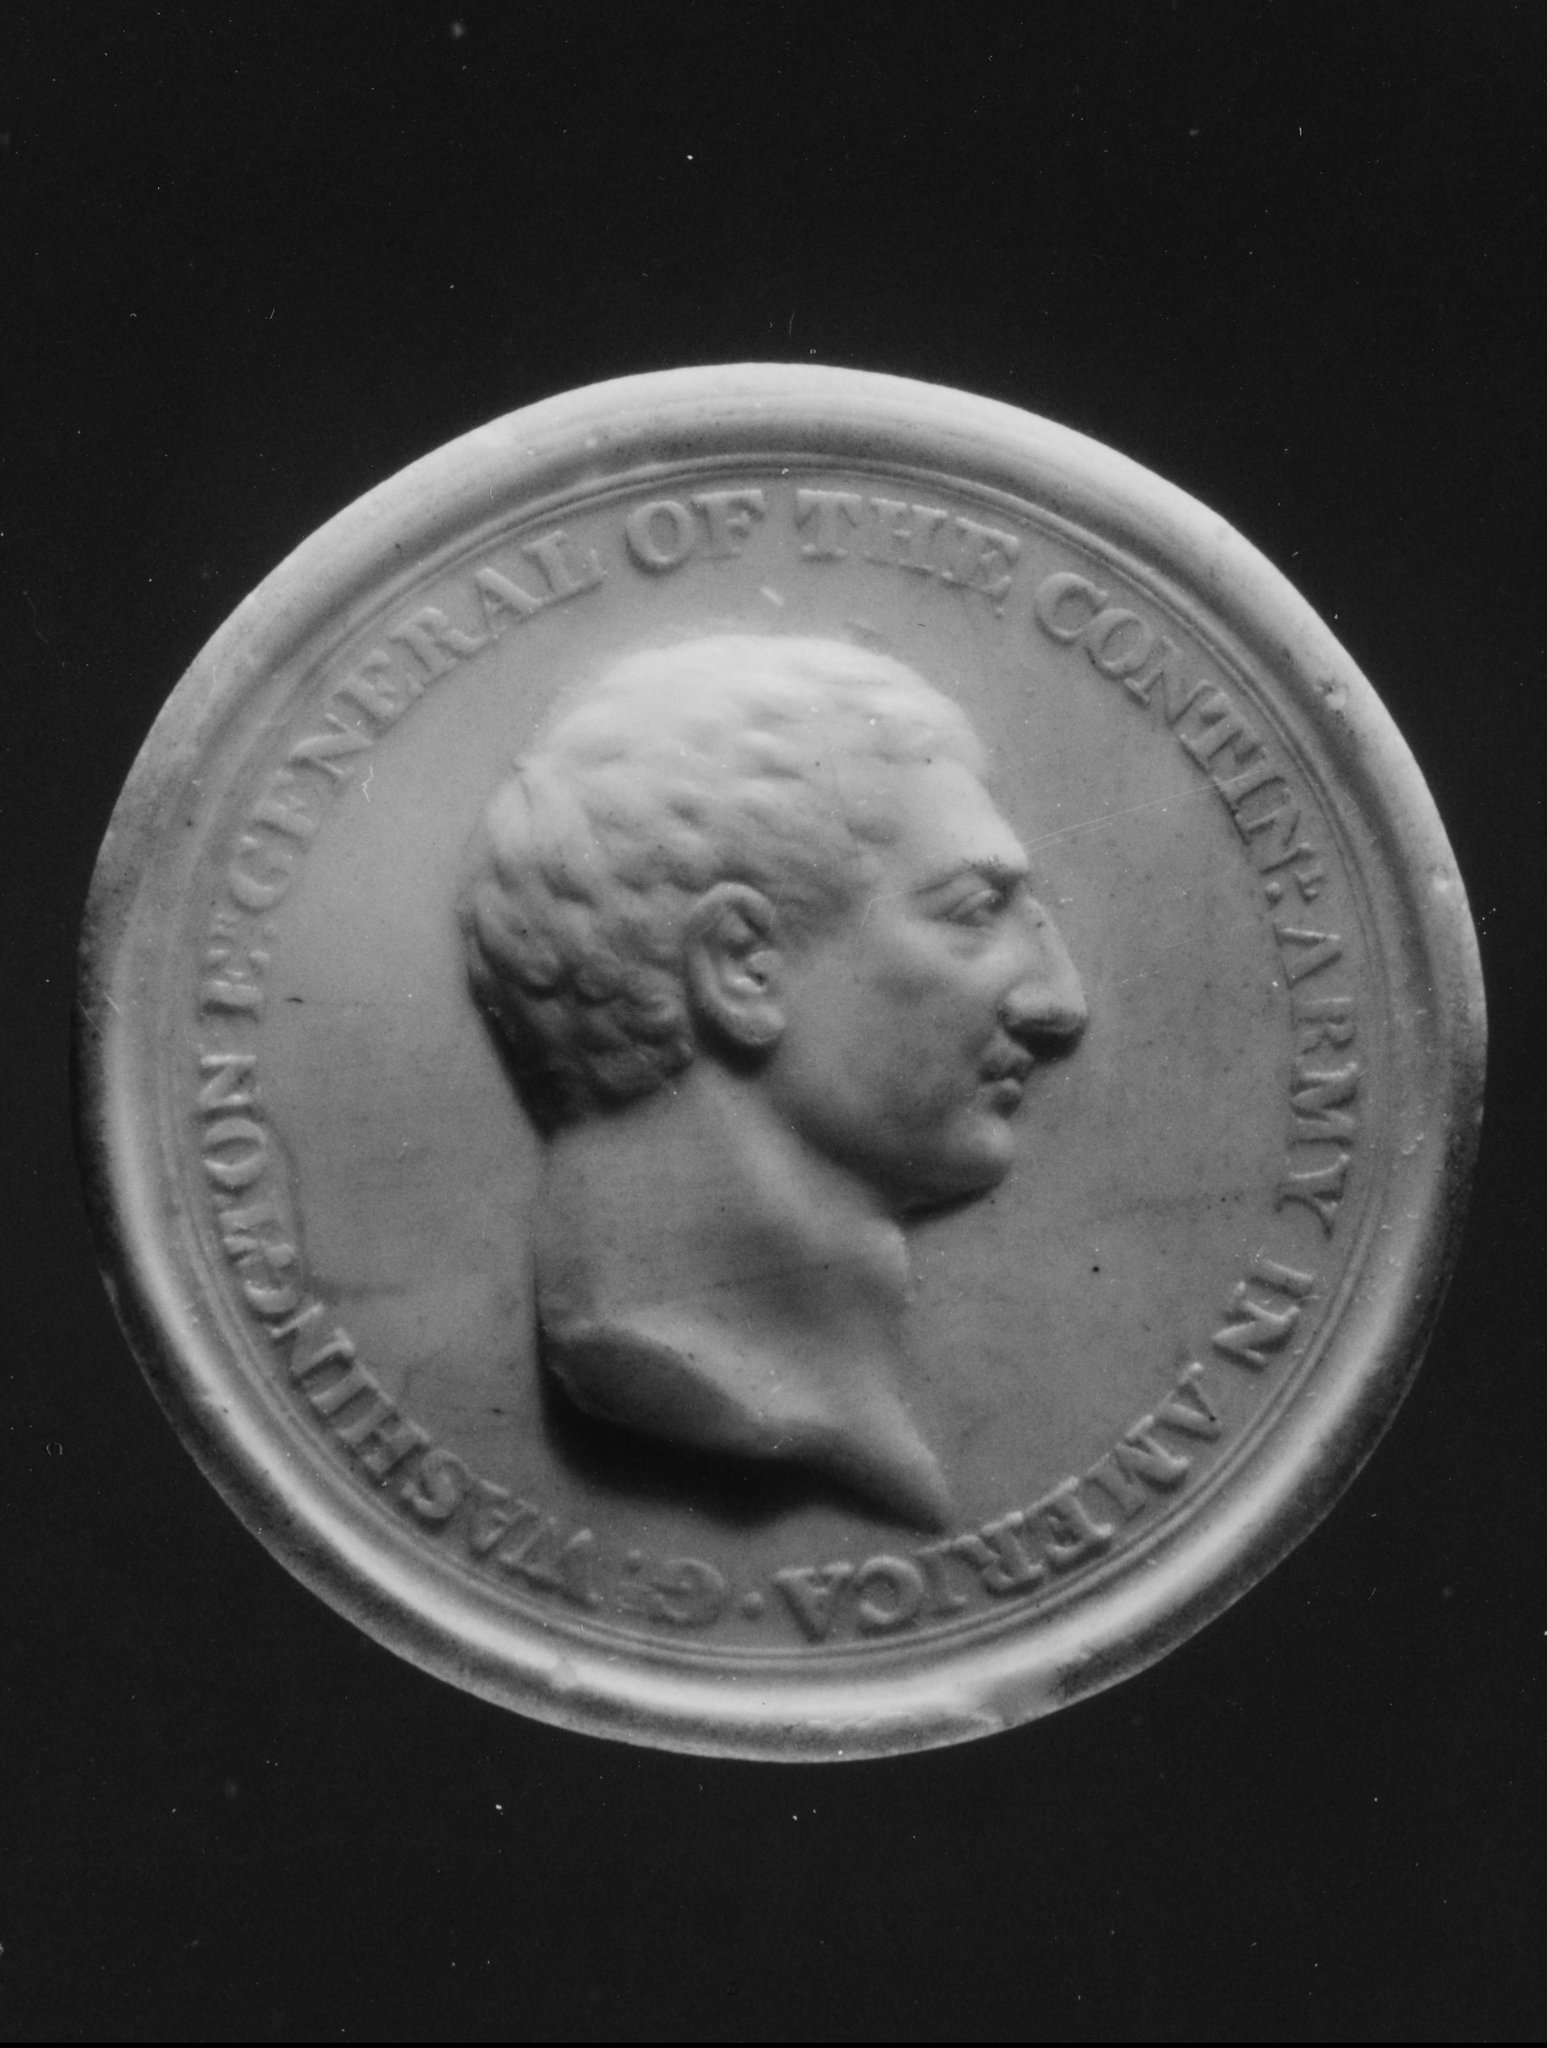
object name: plaque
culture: french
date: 1770-1800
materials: porcelain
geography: france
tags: men,profiles